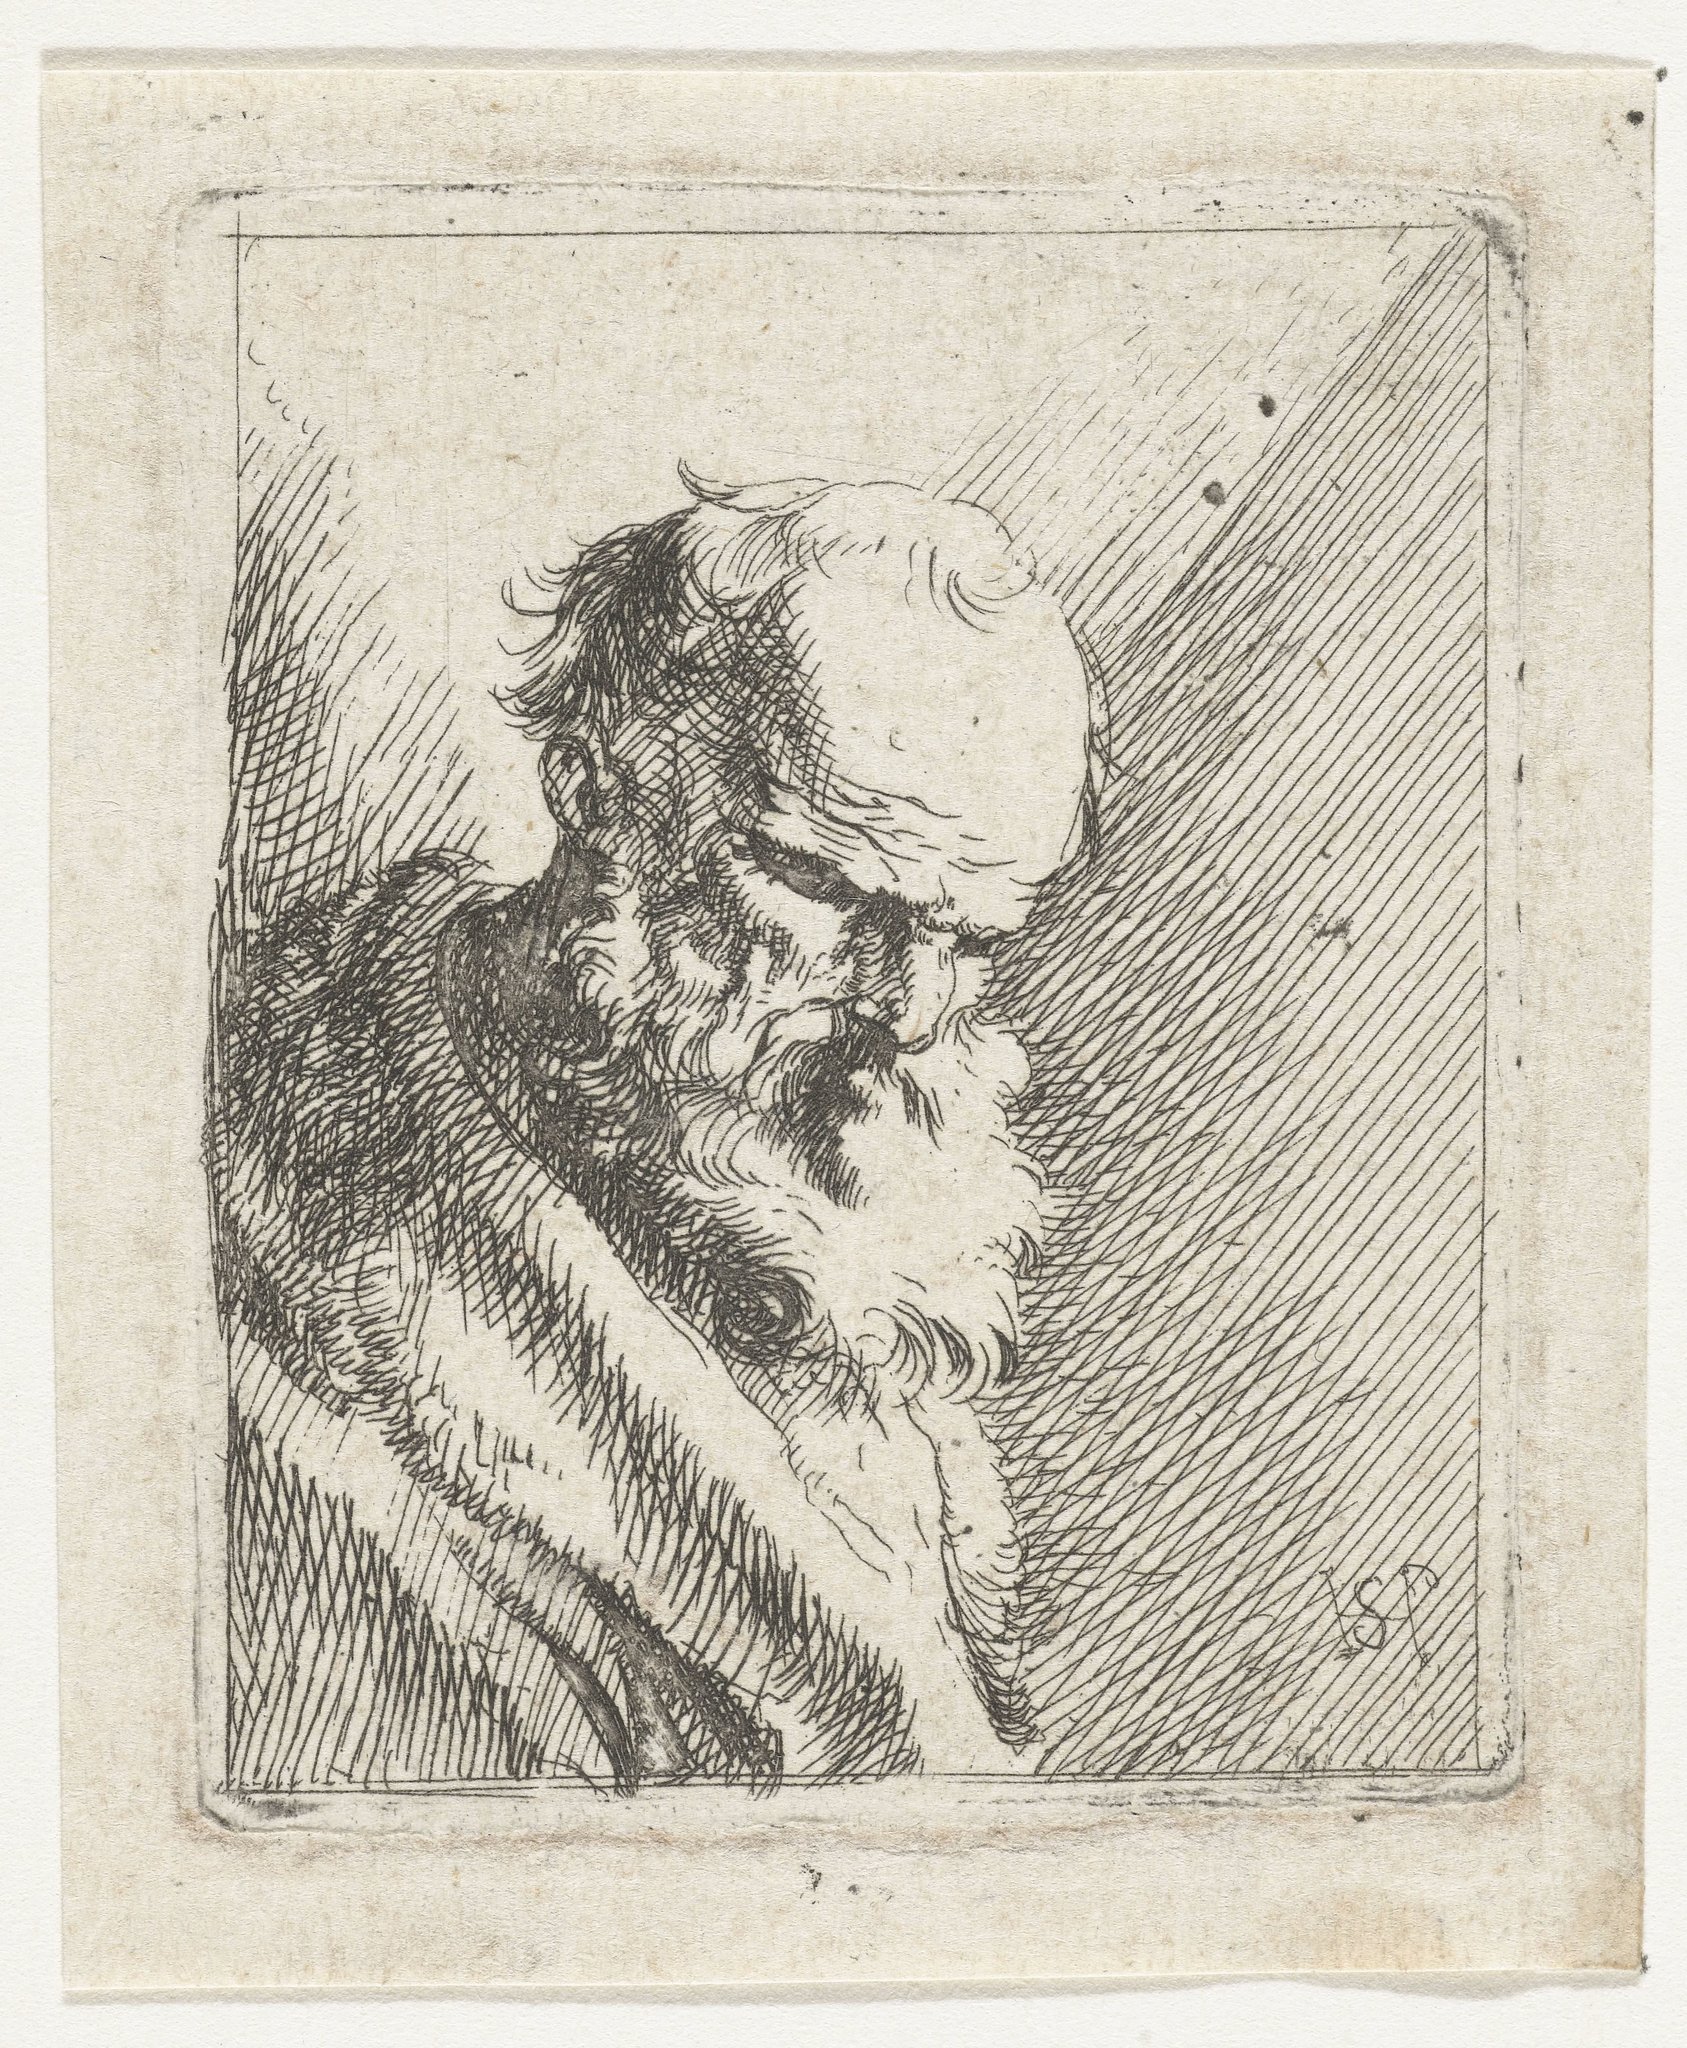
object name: print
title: Tronies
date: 1626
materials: paper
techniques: etching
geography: augsburg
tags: old man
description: Gebaseerd op de verschillende staten van de titelprent van deze serie (voor tweede staat zie RP-P-2002-384), is deze serie in ieder geval vier keer uitgeven. Voor het eerst in 1626 (jaartal vermeld op titelprent) en vervolgens in ieder geval drie keer door de Augsburgse uitgever Jeremias Wolf, die van 1686 tot 1724 actief was. Het is onduidelijk tot welke uitgave dit exemplaar behoort.